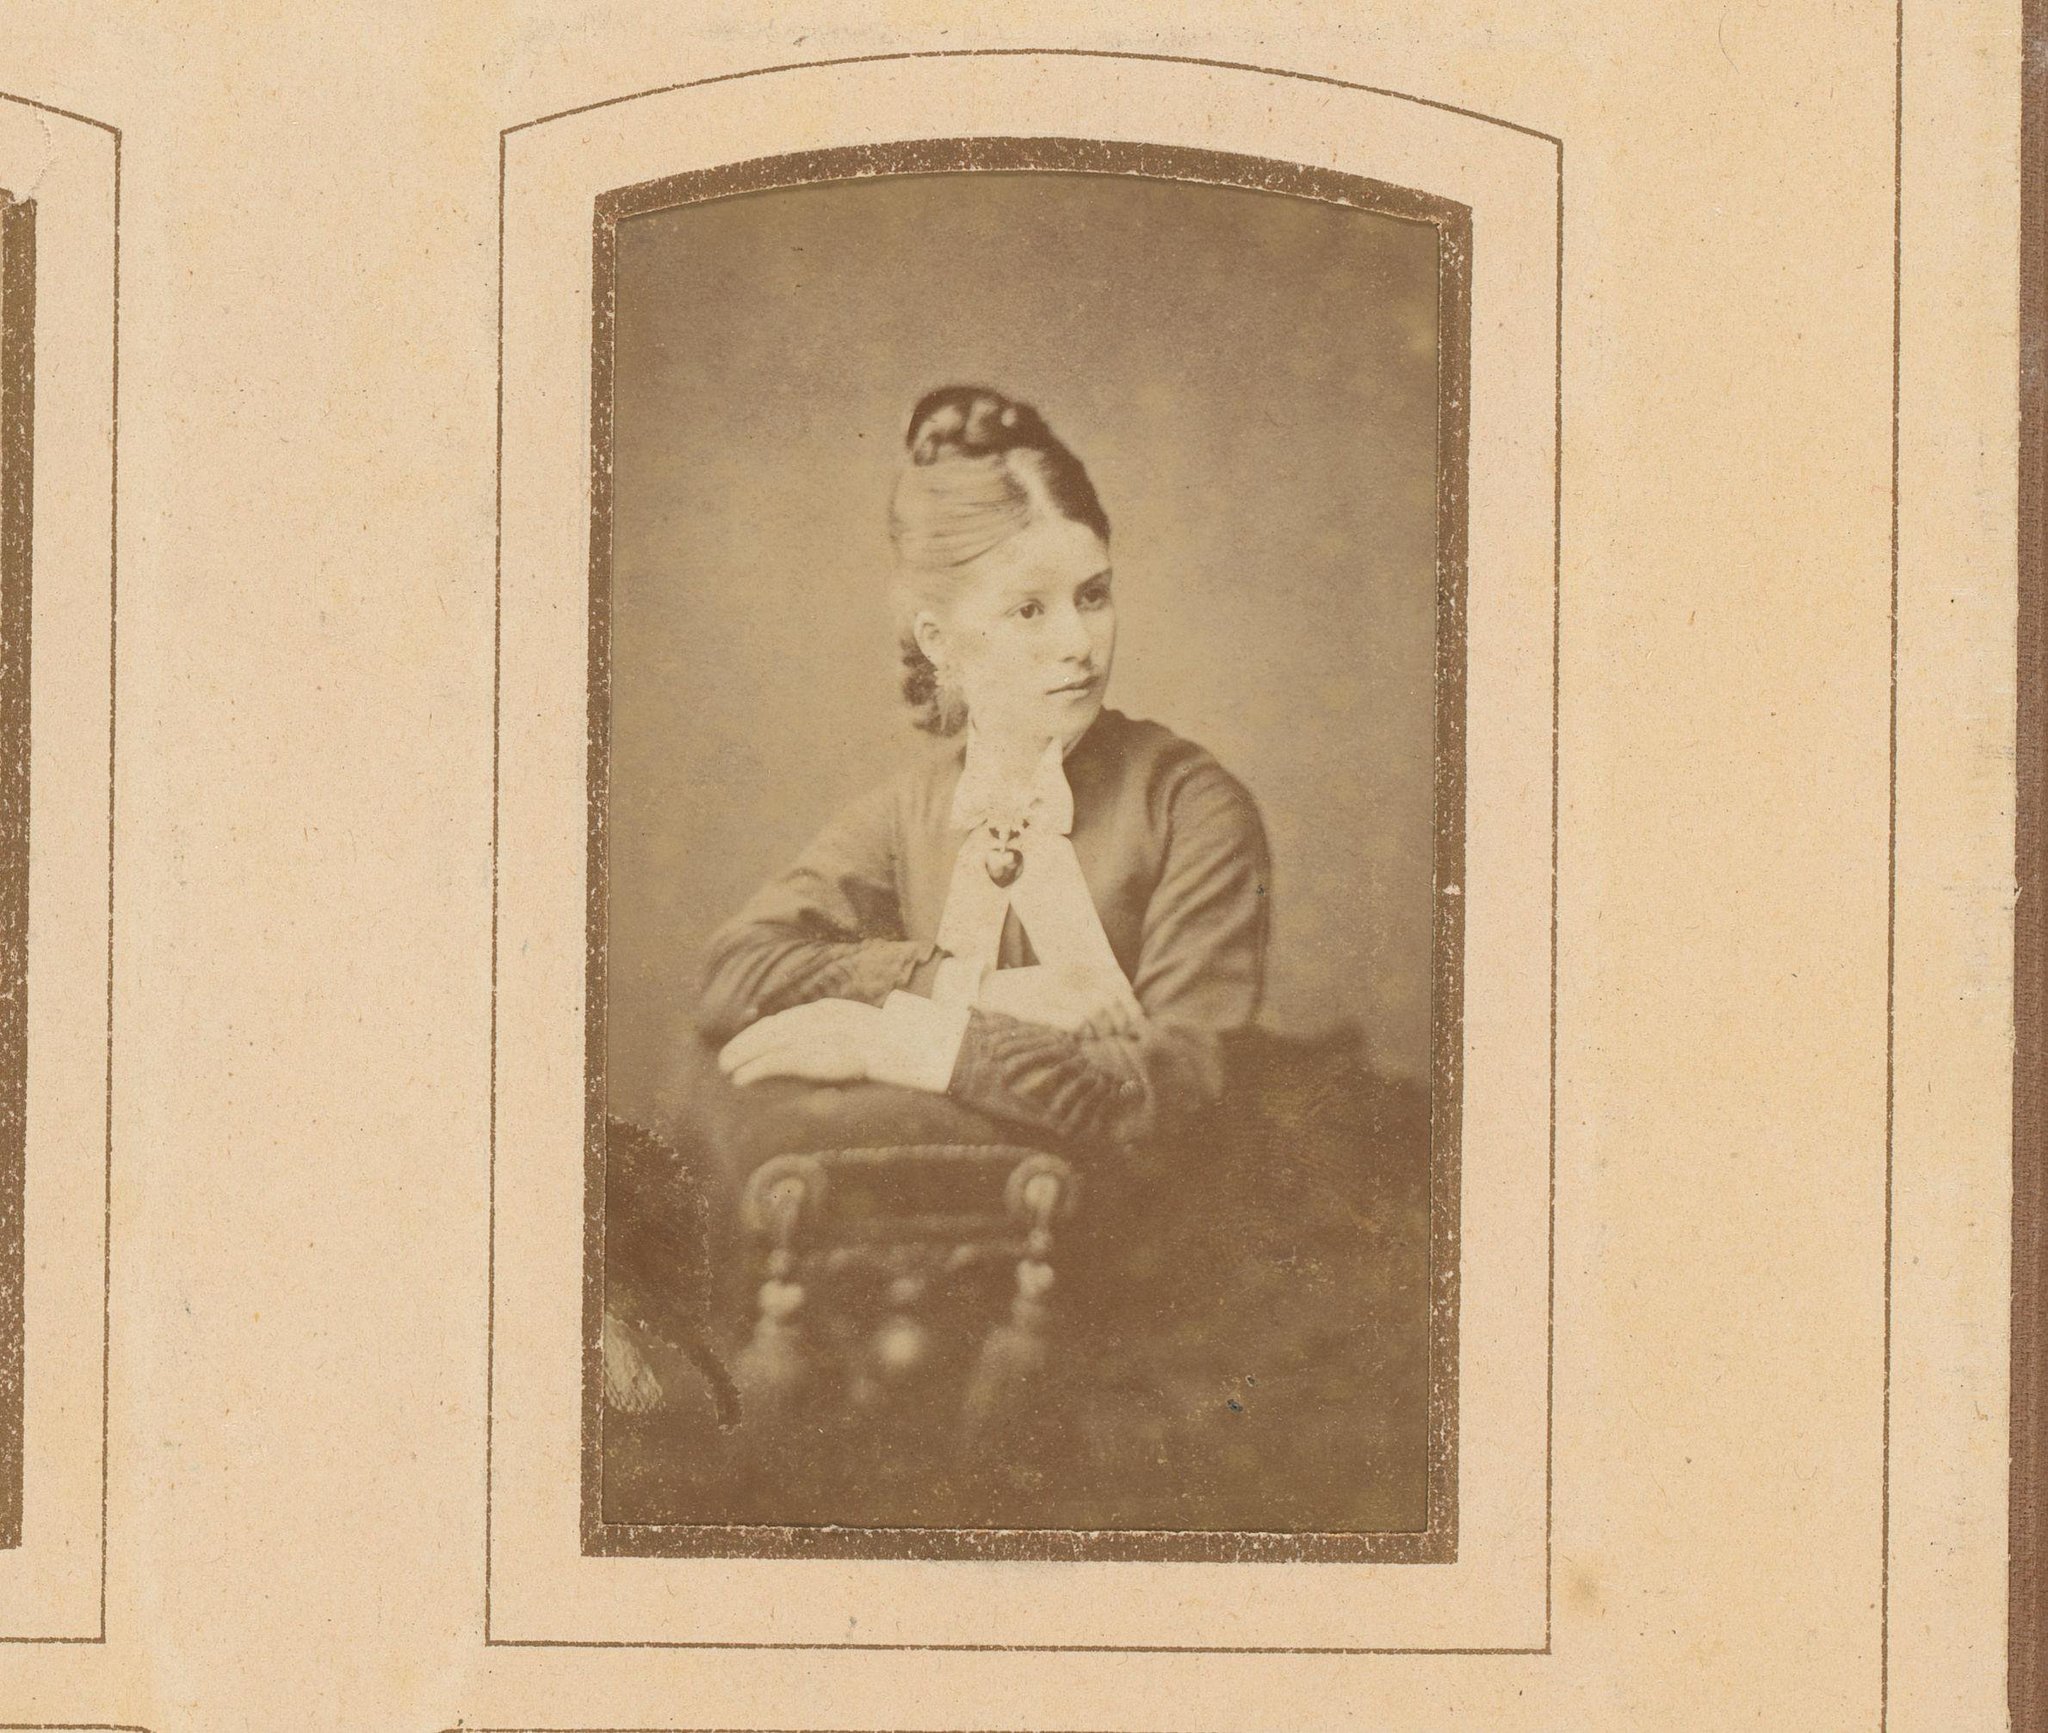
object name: carte de visite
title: Portret van een jonge vrouw met halsketting met hartvormig medaillon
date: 1860-1880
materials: cardboard, photographic support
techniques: albumen print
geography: bath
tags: adolescent, young woman, maiden, historical persons - bb - woman, pendant, trinket, 'breloque'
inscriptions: inscription: ‘Greene,/ 3, Old Bond Street,/ Bath.’